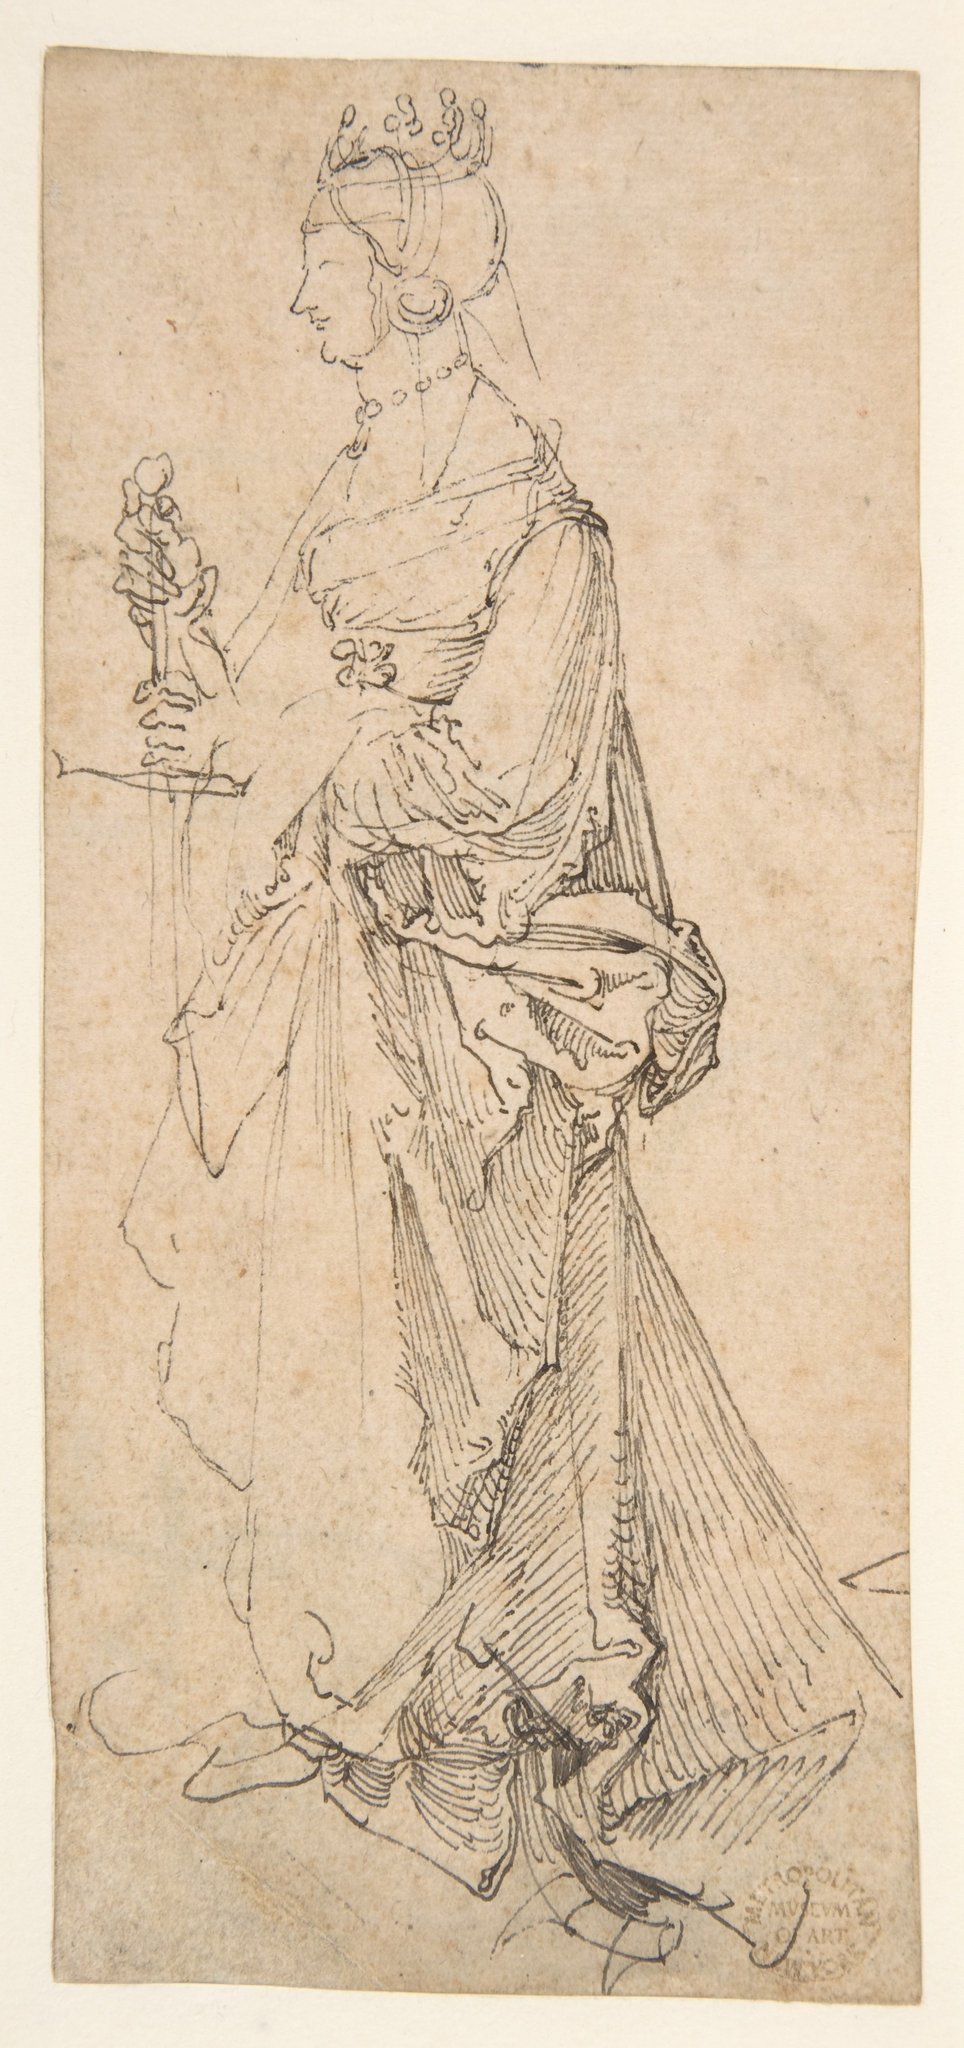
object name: drawing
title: Saint Catherine of Alexandria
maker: albrecht dürer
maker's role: artist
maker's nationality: german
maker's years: 1471-1528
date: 1490-1528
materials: ink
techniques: pen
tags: saint catherine